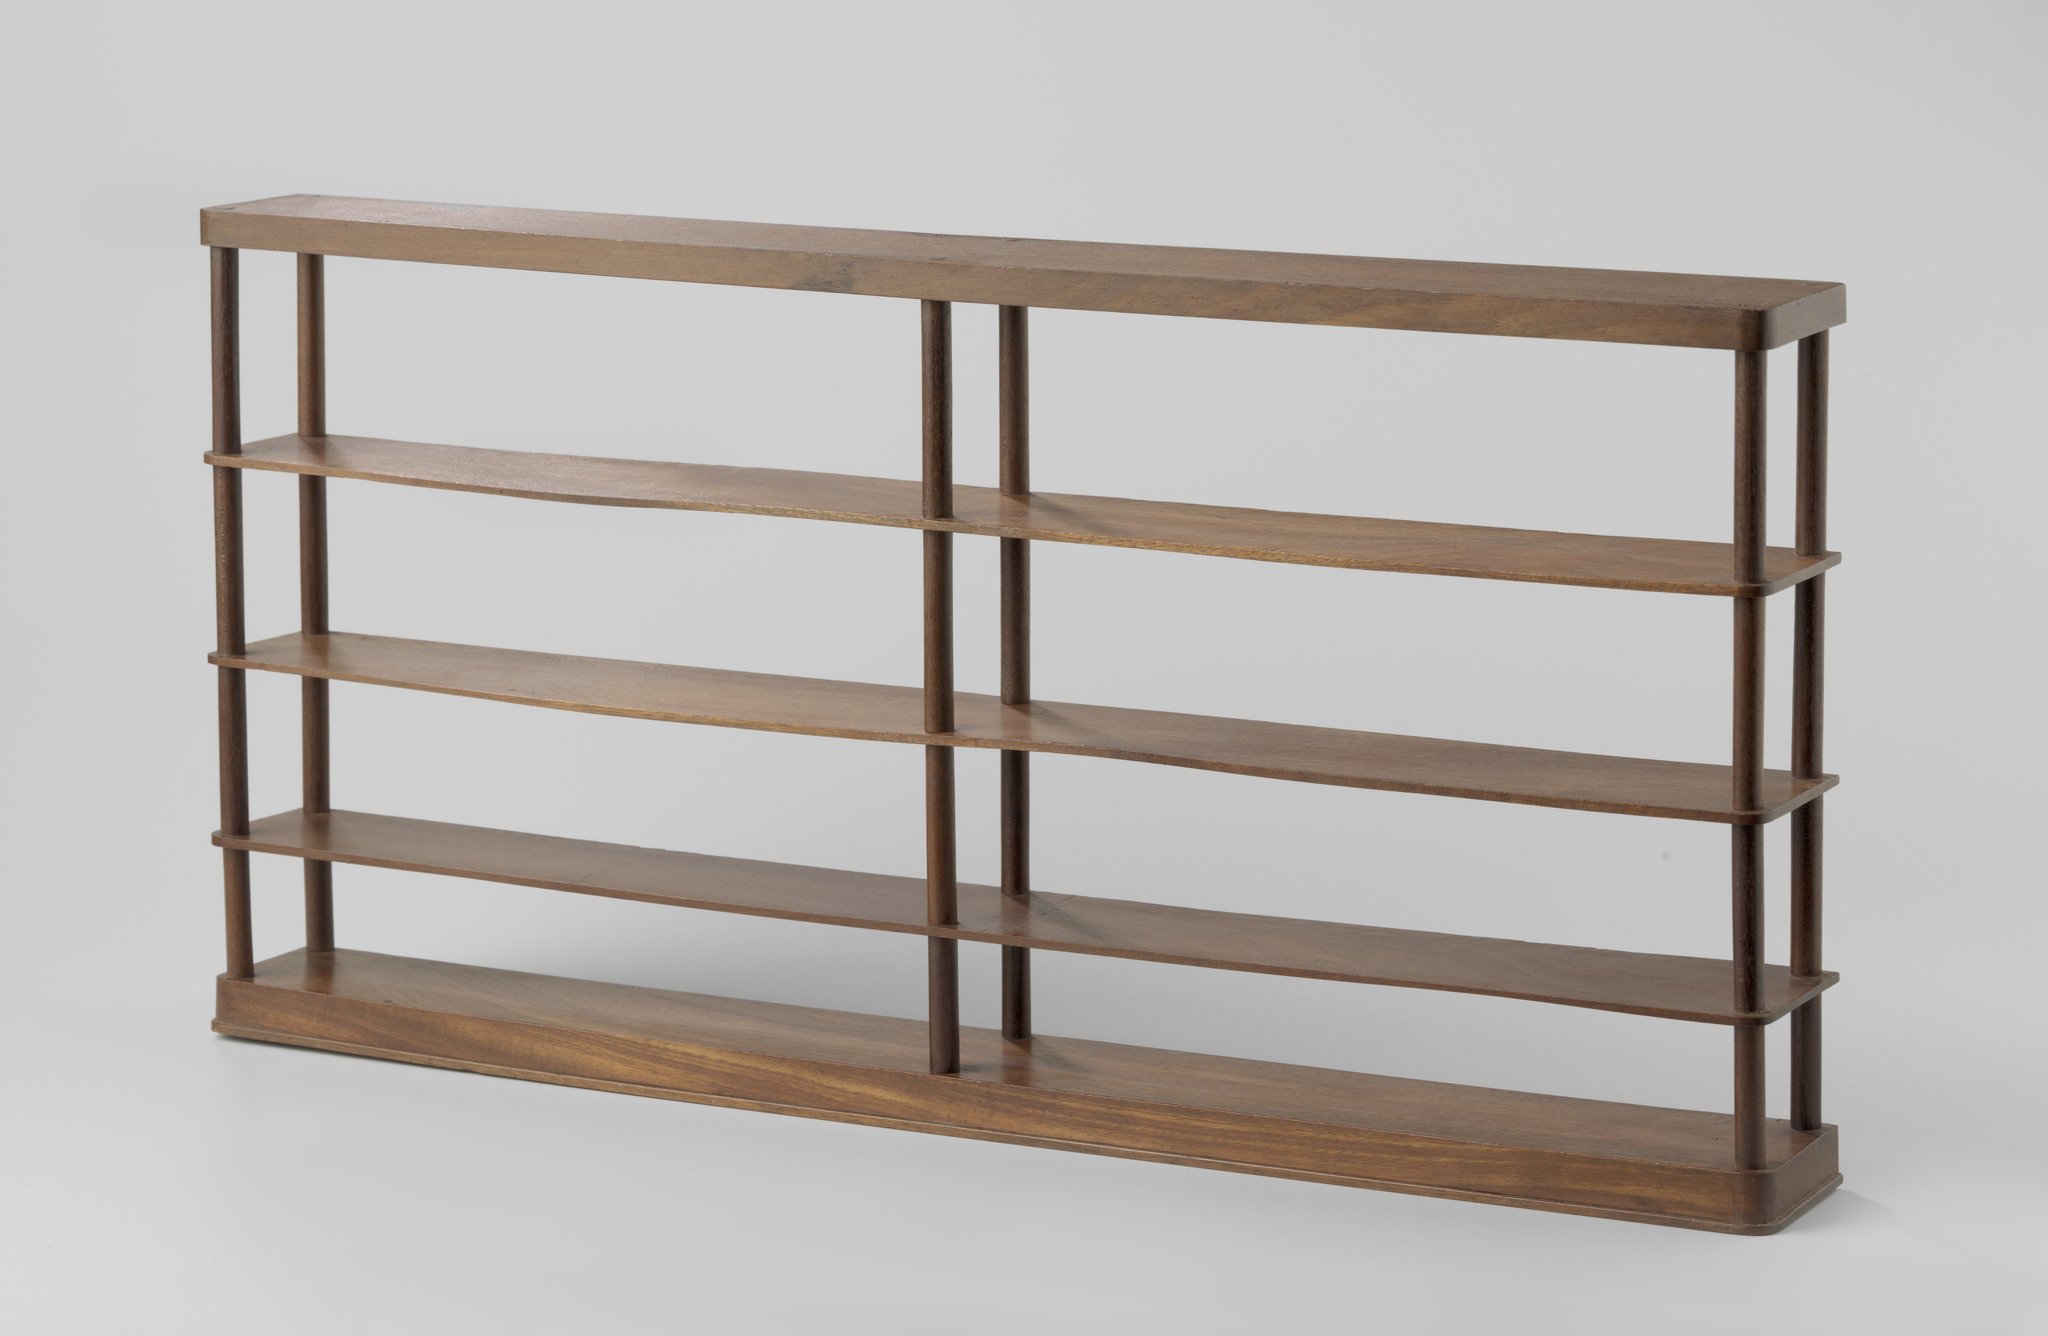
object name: miniature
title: Stellingkast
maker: Anonymous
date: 1820-1840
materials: wood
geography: amsterdam